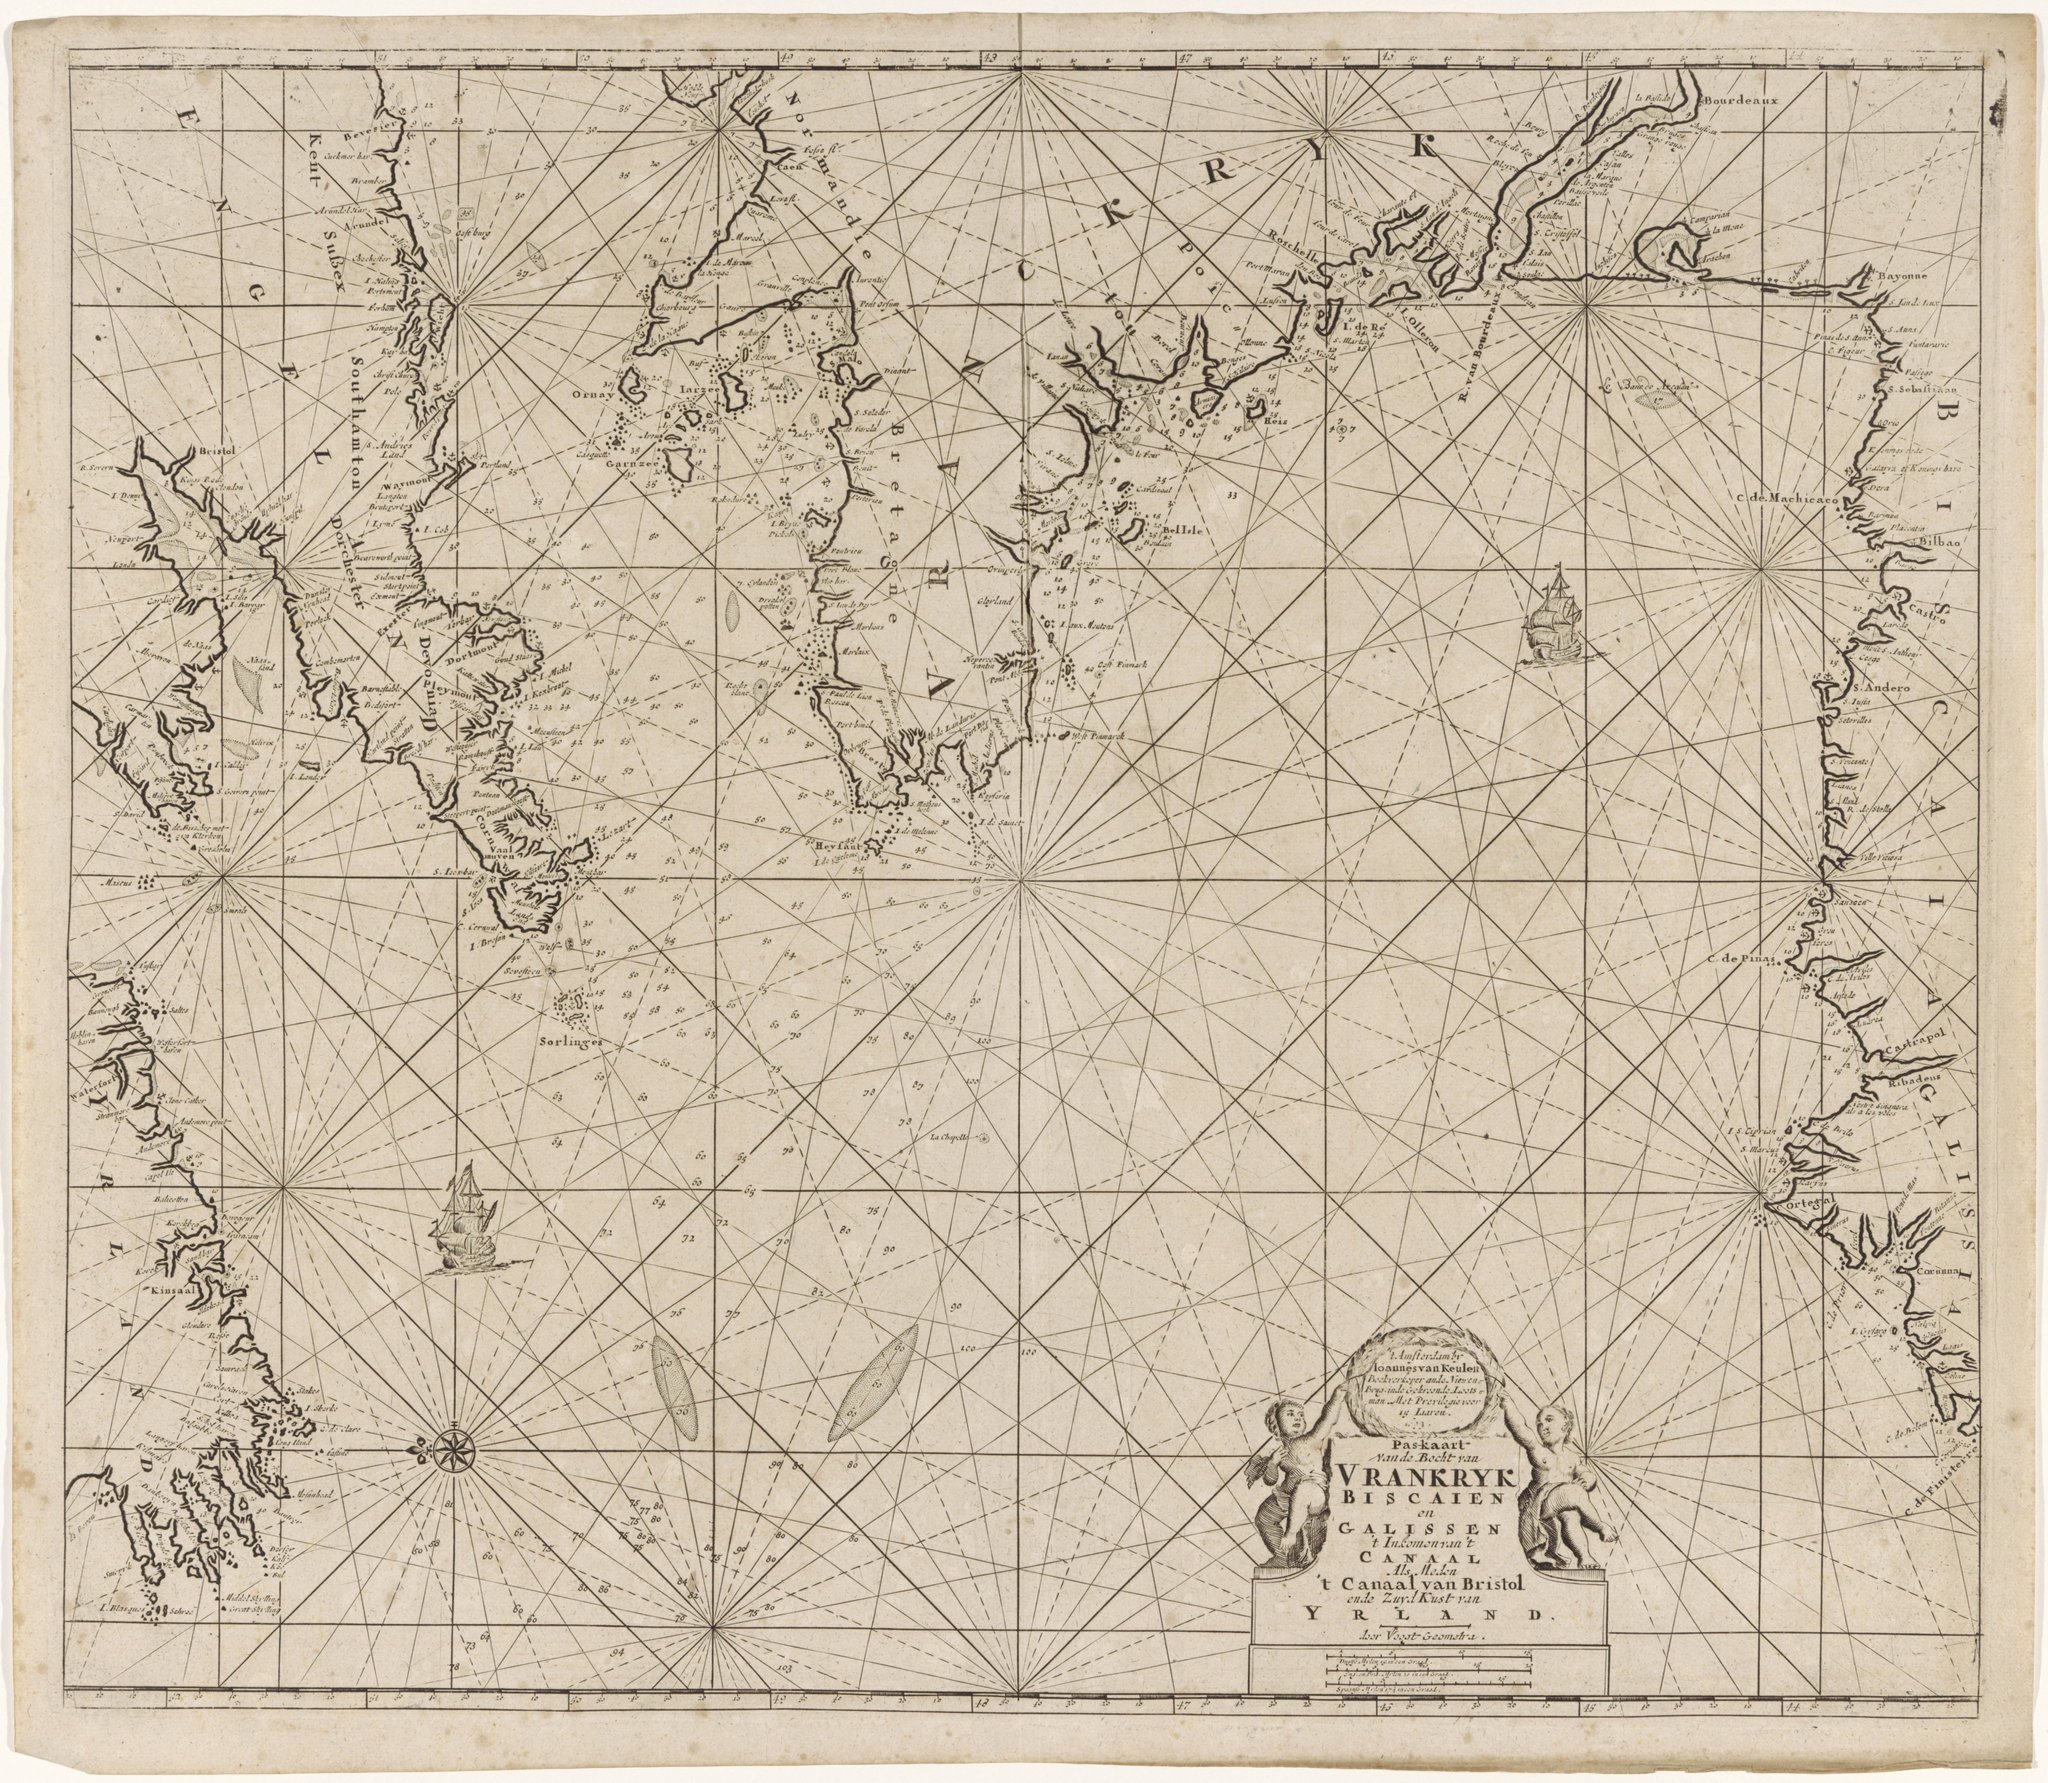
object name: print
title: Pas-kaart van de Bocht van Vrankryck Biscaien en Galissen 't inkomen van 't Canaal als Meden 't Canaal van Bristol ende Zuydkust van Yrland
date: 1678-1715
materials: paper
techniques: engraving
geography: amsterdam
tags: sailing-ship, sailing-boat, maps, atlases, cupids: 'amores', 'amoretti', 'putti', france, spain, england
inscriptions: collector's mark: Lugt 2228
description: Paskaart van een deel van de kust van Ierland, Engeland, Frankrijk en Spanje, met de Golf van Biskaje. Links een kompasroos, het Noorden ligt links. Rechts een door twee putti geflankeerde cartouche met de titel, waaronder de schaal in Duitse, Spaanse en Engelse of Franse mijlen.